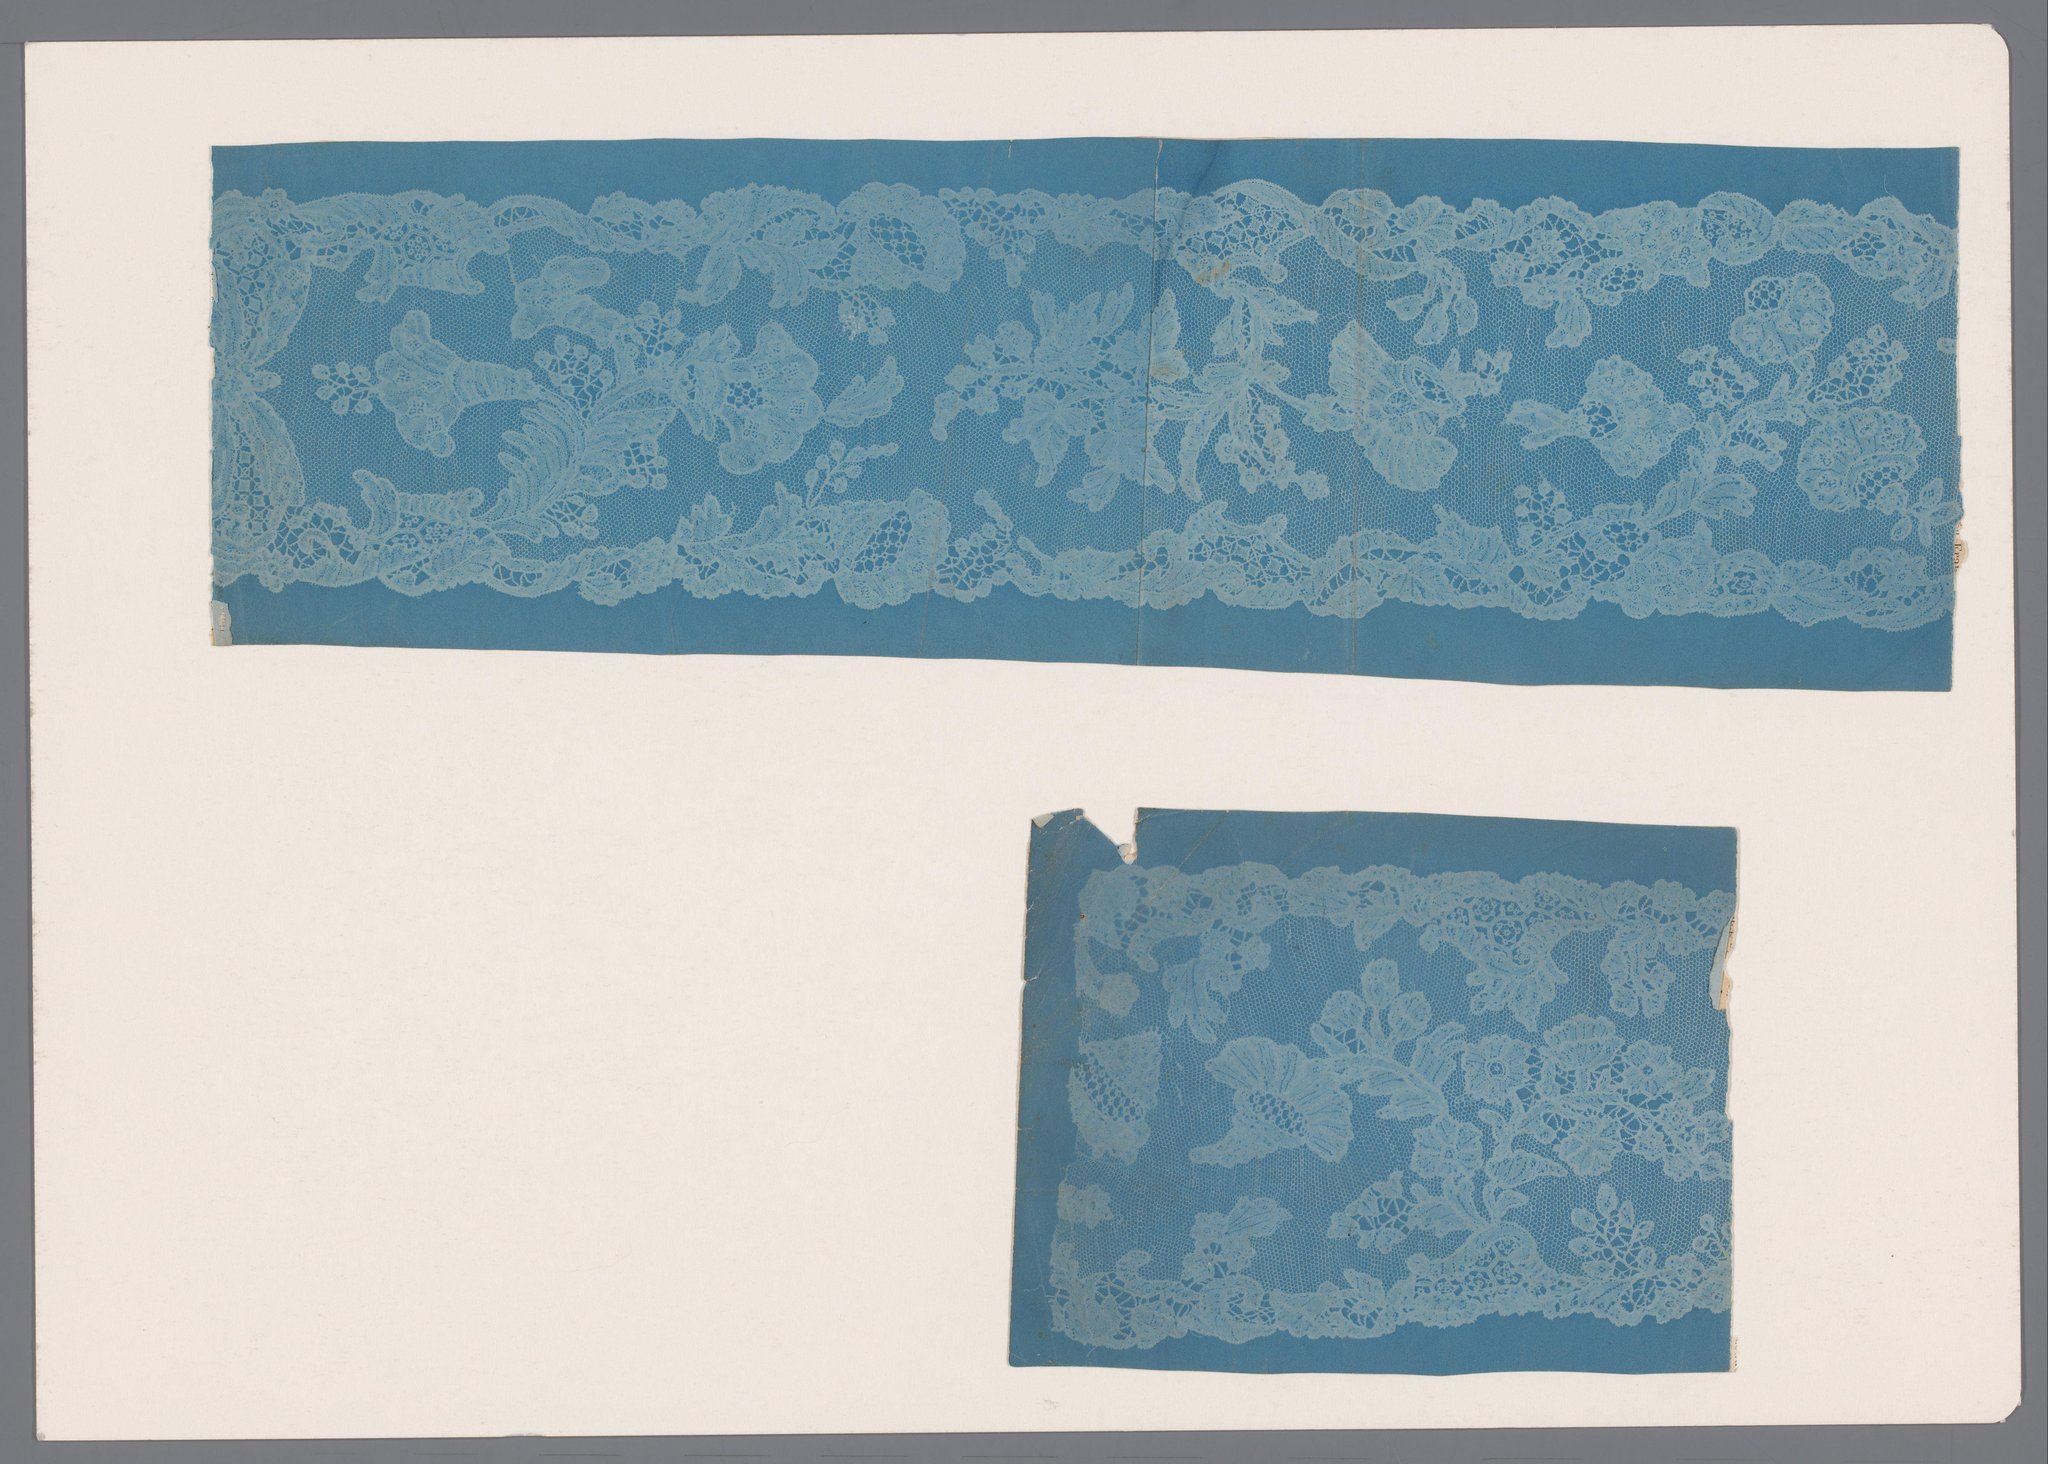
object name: photogram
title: Twee voorbeelden van kant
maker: Anonymous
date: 1890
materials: paper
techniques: cyanotype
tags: lace